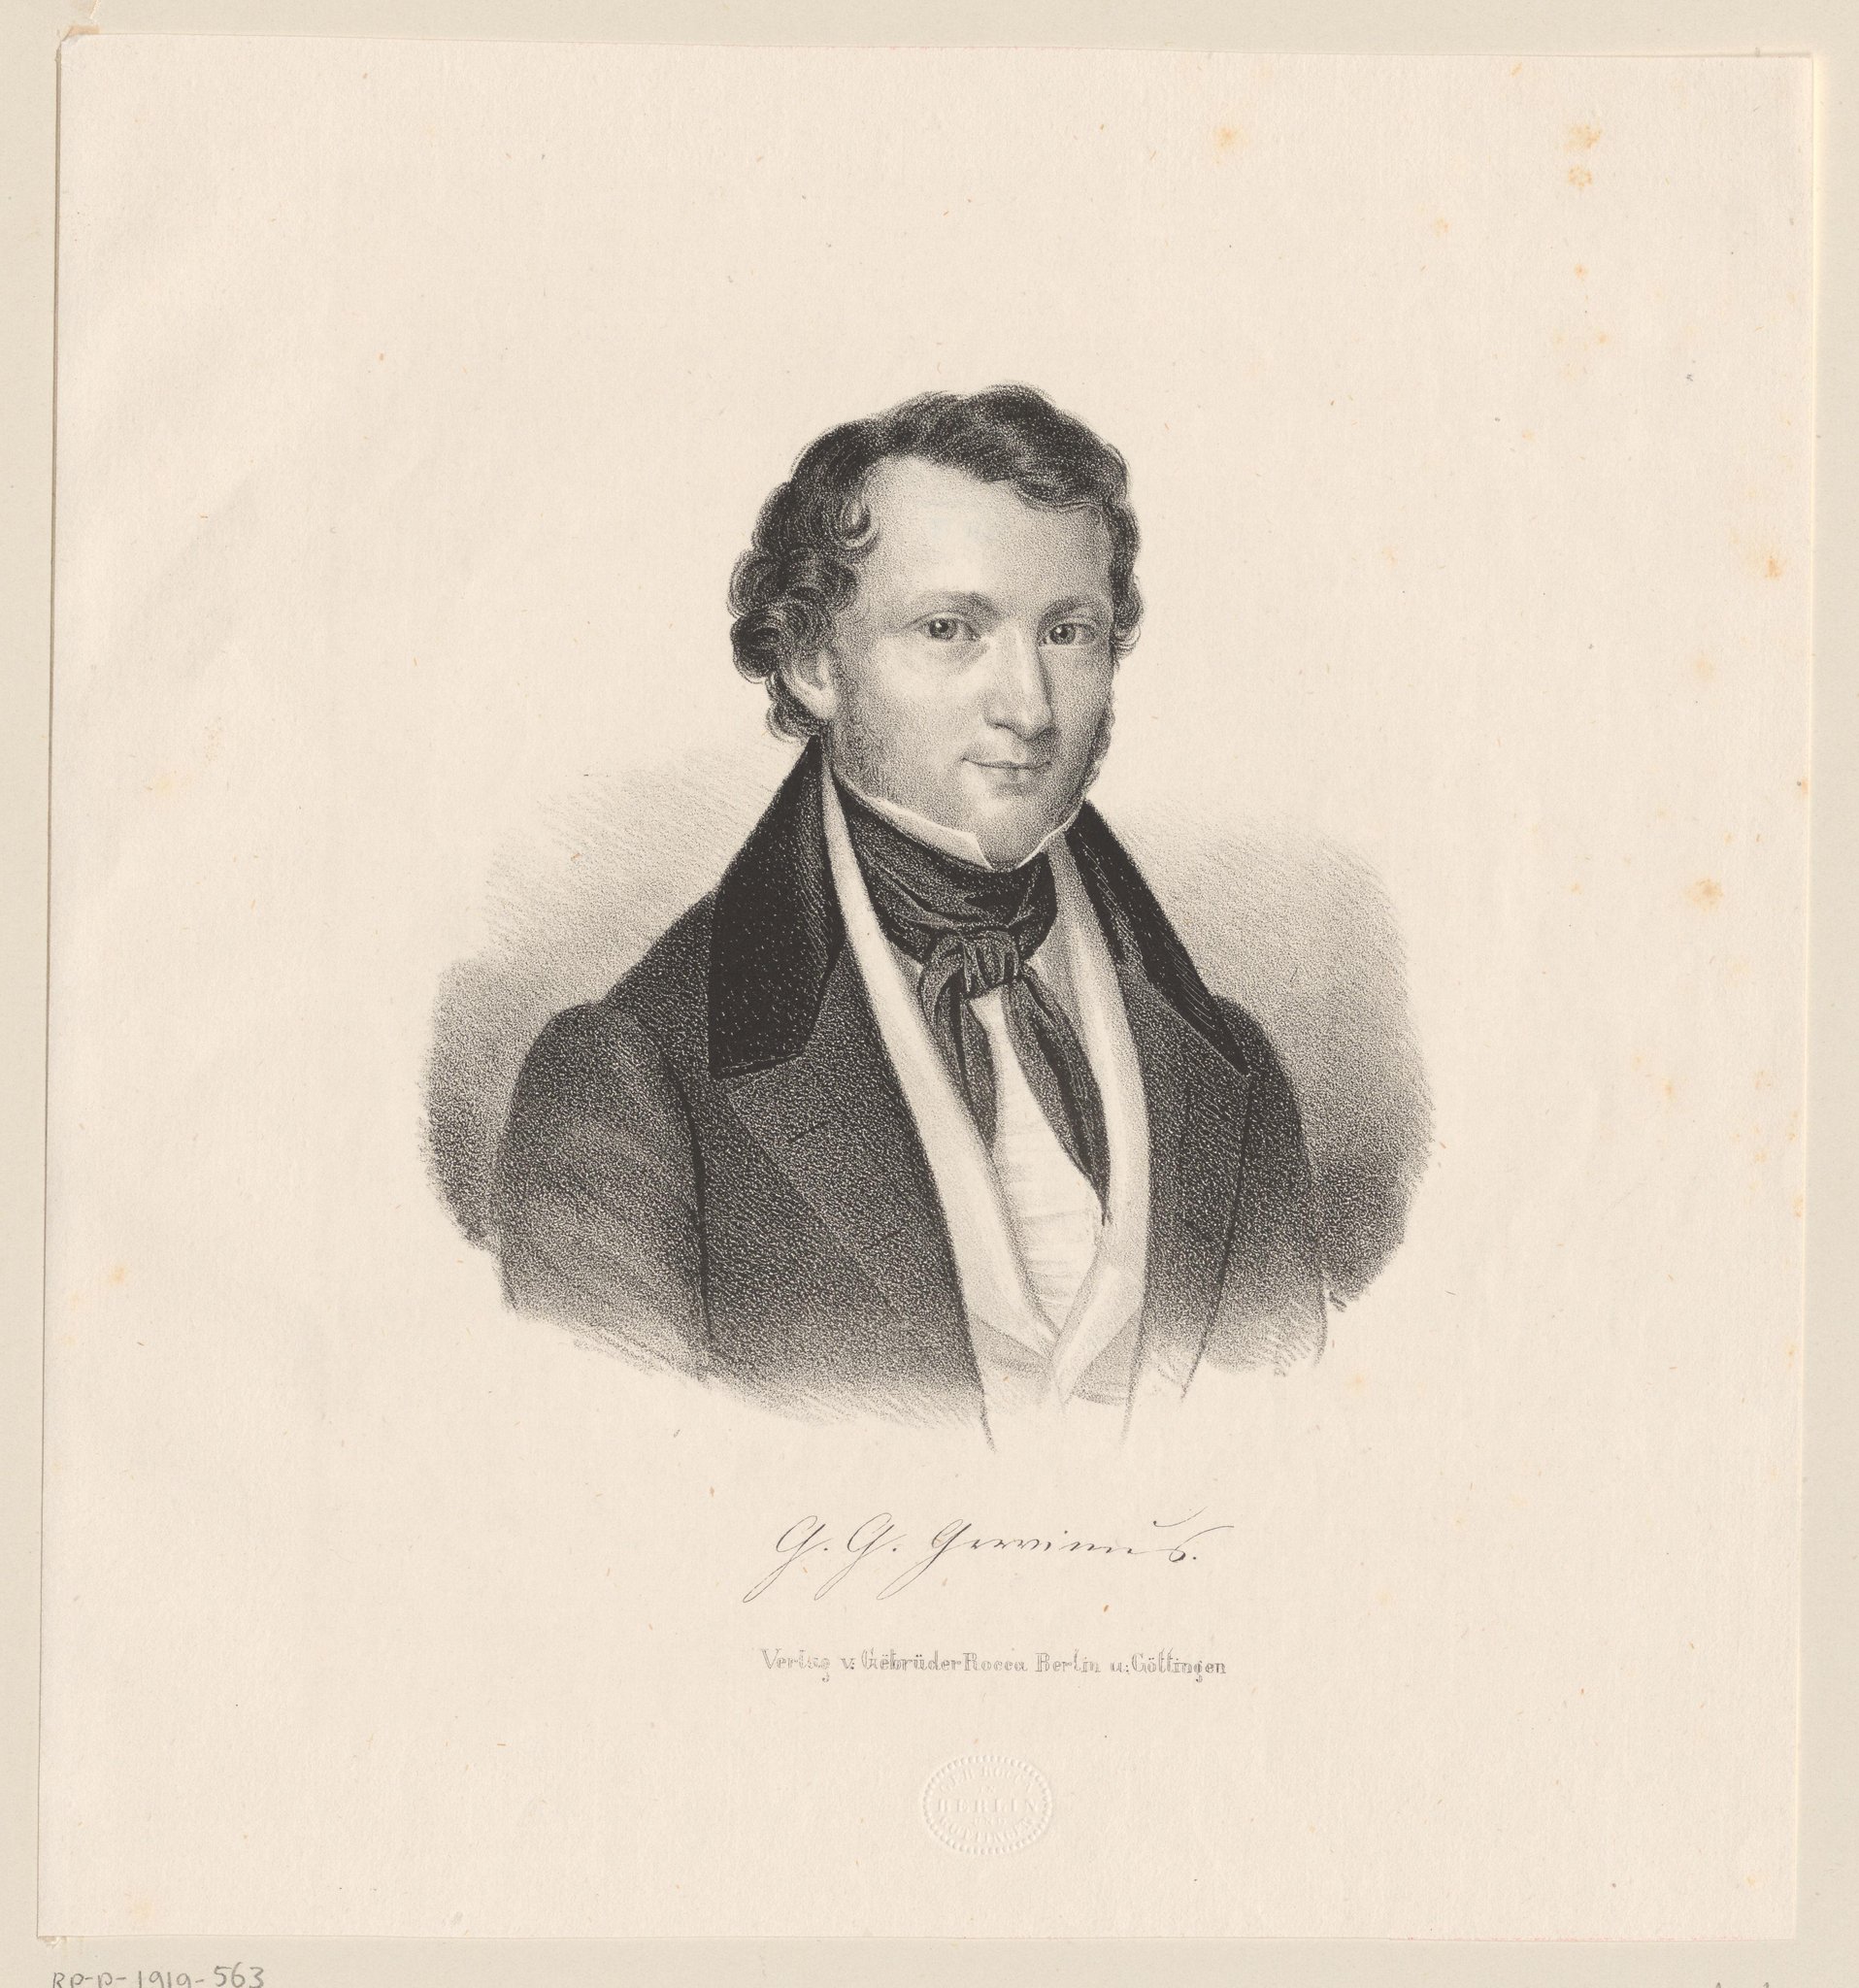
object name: print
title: Portret van Georg Gottfried Gervinus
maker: Anonymous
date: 1815-1874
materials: paper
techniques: lithograph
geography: gottingen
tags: history and archaeology (+ portrait of scholar, scientist), historical persons, professor, merchant, salesman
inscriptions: collector's mark: Lugt 2228